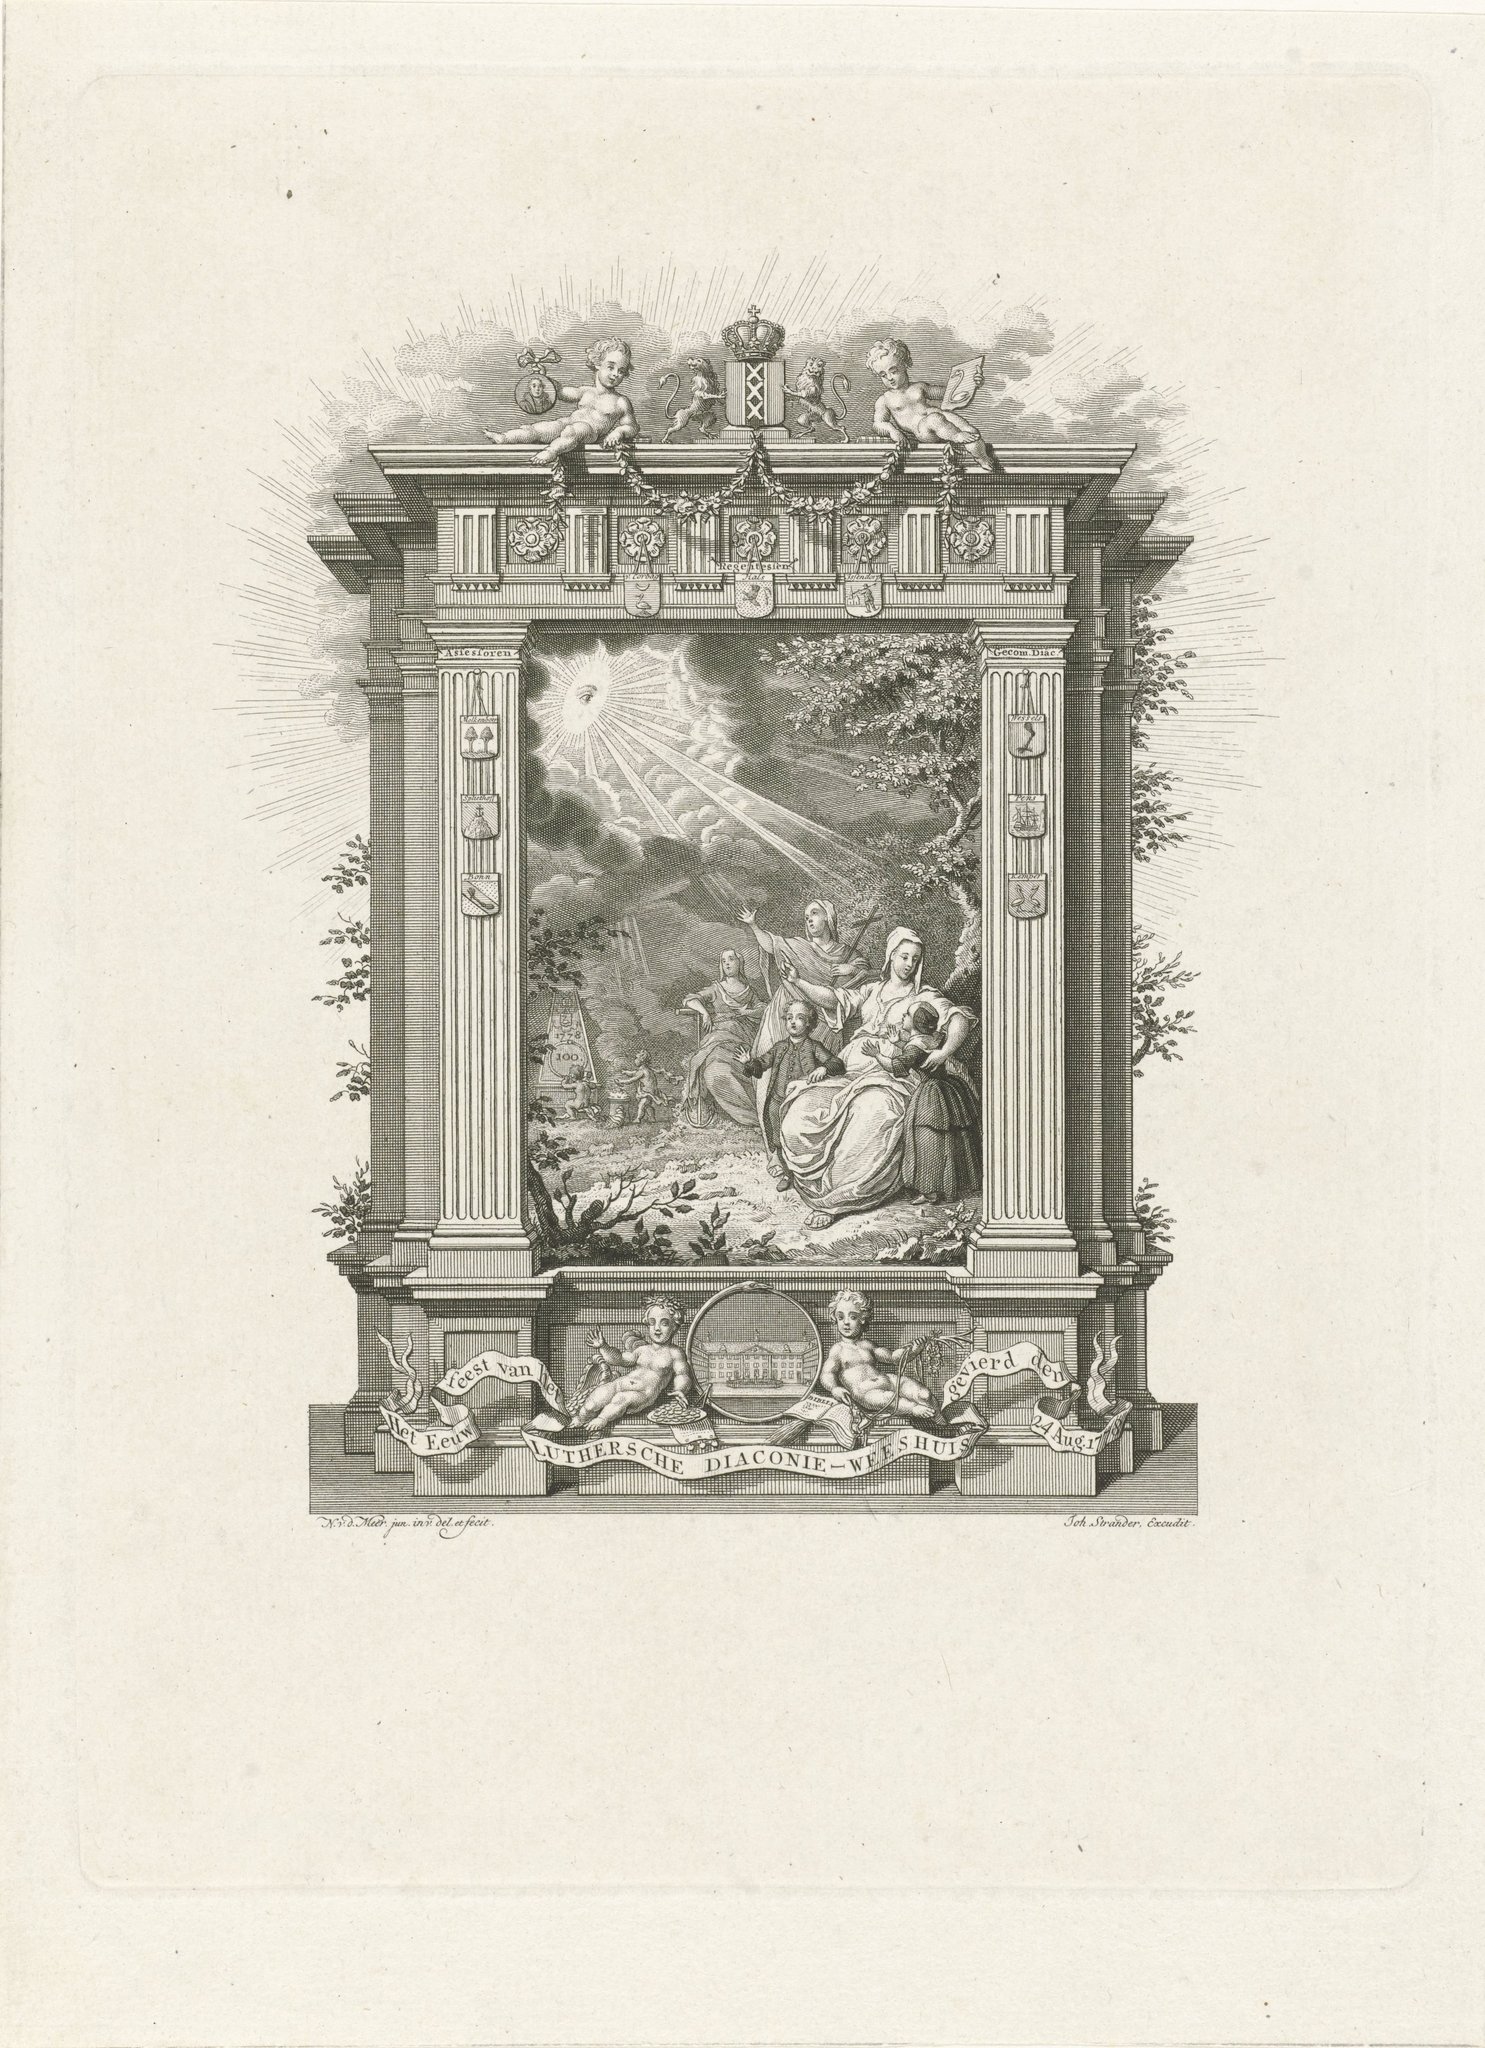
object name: print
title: Allegorie op het eeuwfeest van het Lutherse Diaconieweeshuis te Amsterdam, 1778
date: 1778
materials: paper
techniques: engraving, etching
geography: amsterdam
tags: charity, 'caritas'; 'carità' (ripa) ~ one of the three theological virtues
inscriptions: collector's mark: Lugt 2228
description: Titelplaat met een allegorie op het eeuwfeest van de Lutherse Diaconessen Weeshuis te Amsterdam, gevierd op 24 augustus 1778. Allegorische voorstelling van de Liefde met twee weeskinderen beschenen door het goddelijk licht, binnen een erepoort versierd met wapens van regentessen etc., putti en het wapen van van Amsterdam.